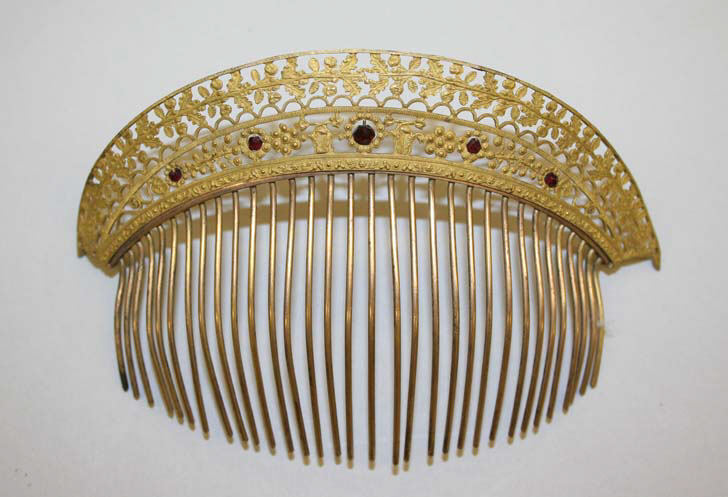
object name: comb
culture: french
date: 1801-1900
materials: glass, metal